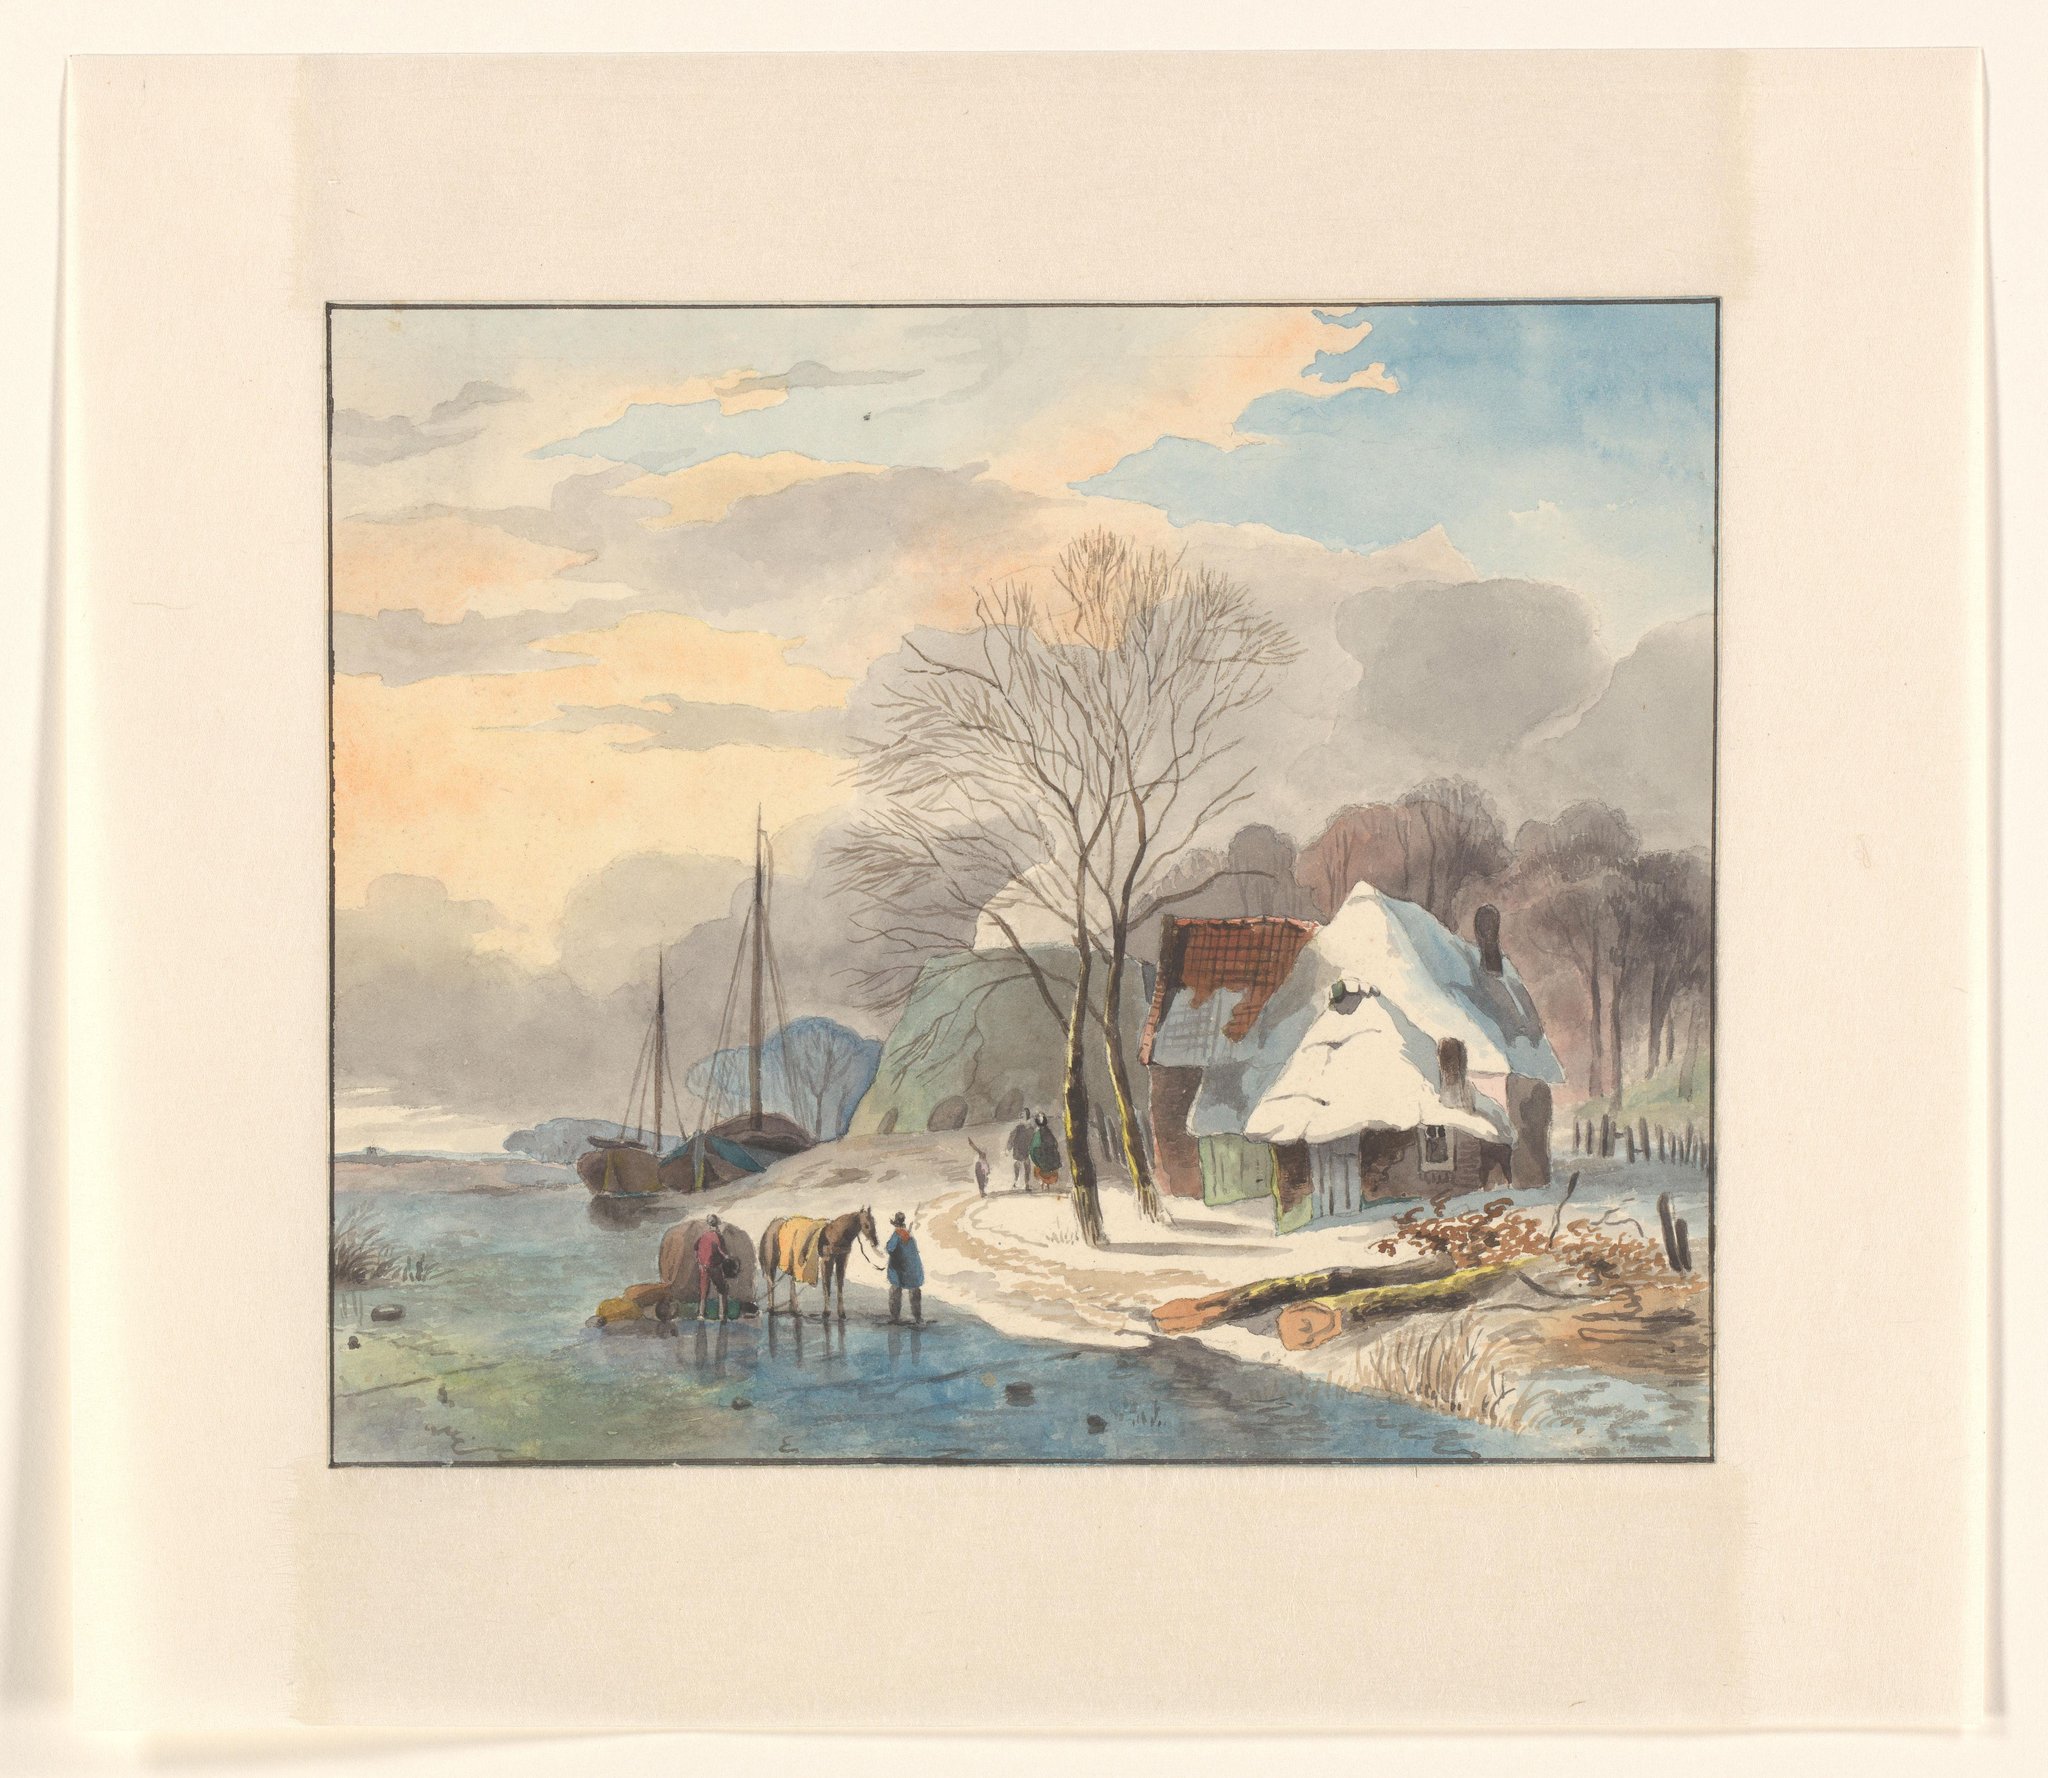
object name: drawing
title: Winterlandschap met boerderij en kalkoven aan een rivier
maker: johannes van reijn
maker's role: draughtsman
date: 1800-1900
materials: paper, pencil, watercolor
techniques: brush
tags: industries ~ clay, sand, chalk, etc., landscapes, winter, 'hyems'; 'inverno' (ripa)